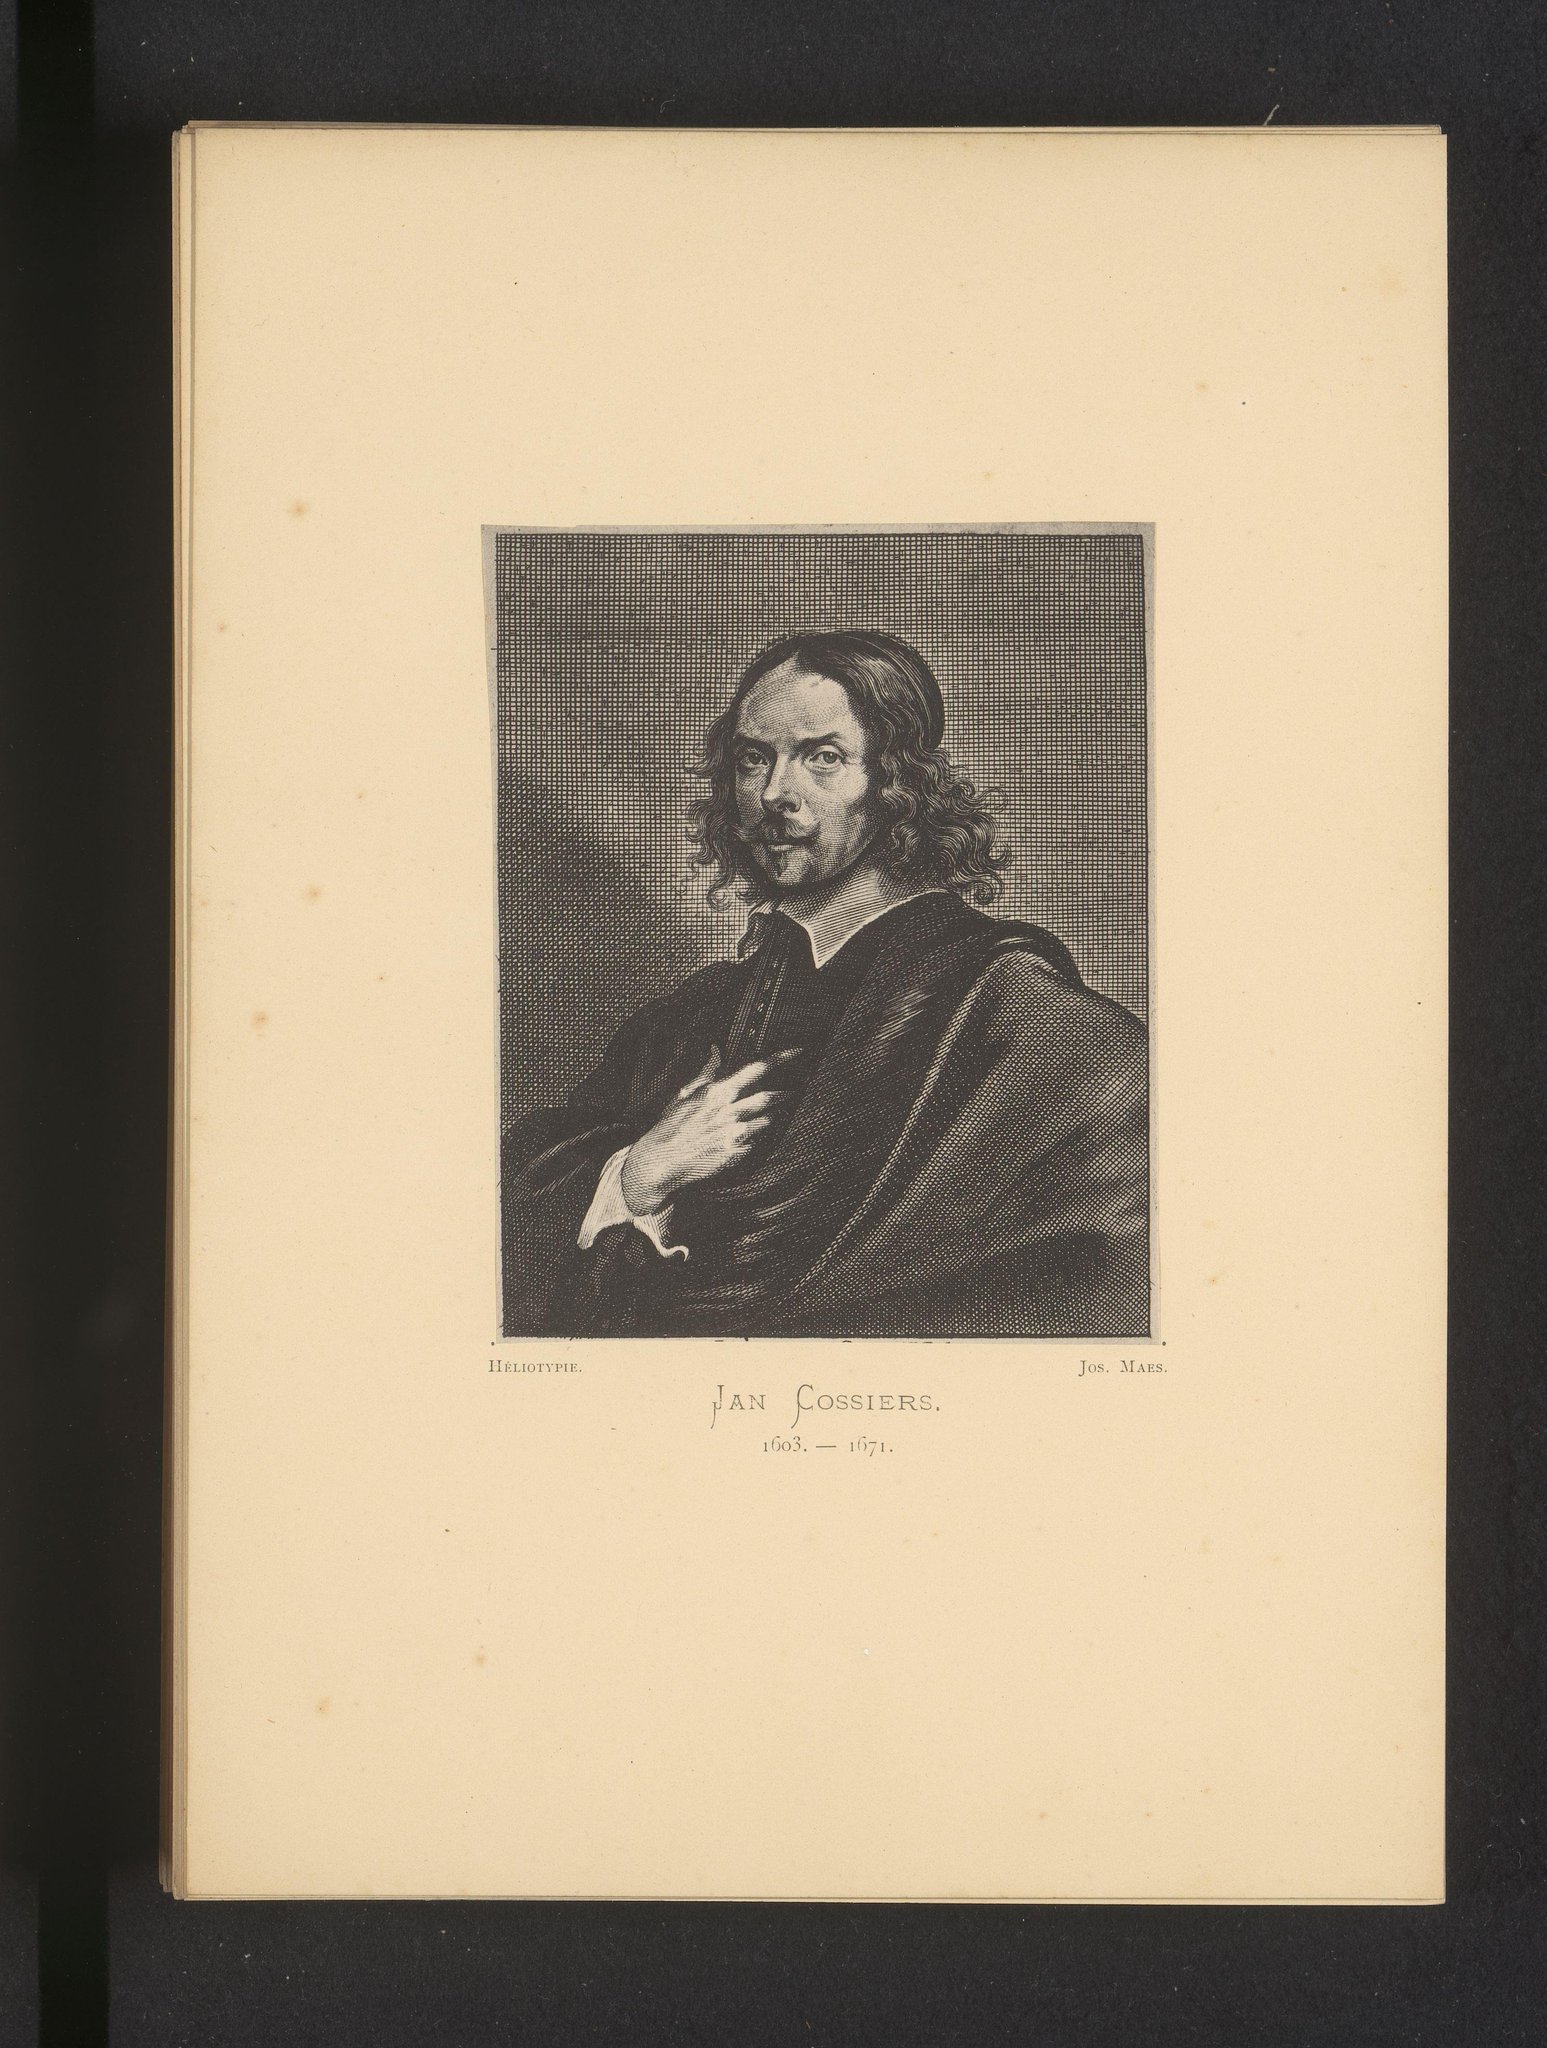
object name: photomechanical print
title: Jan Cossiers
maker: joseph maes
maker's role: fotograaf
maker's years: 1838-1908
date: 1872-1877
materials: cardboard, paper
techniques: photograph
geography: antwerp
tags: jan cossiers, historical persons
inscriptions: inscription: ‘1603. - 1671.’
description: Deze prent maakt deel uit van een omslag met 150 prenten en een katern met een lijst van afbeeldingen.